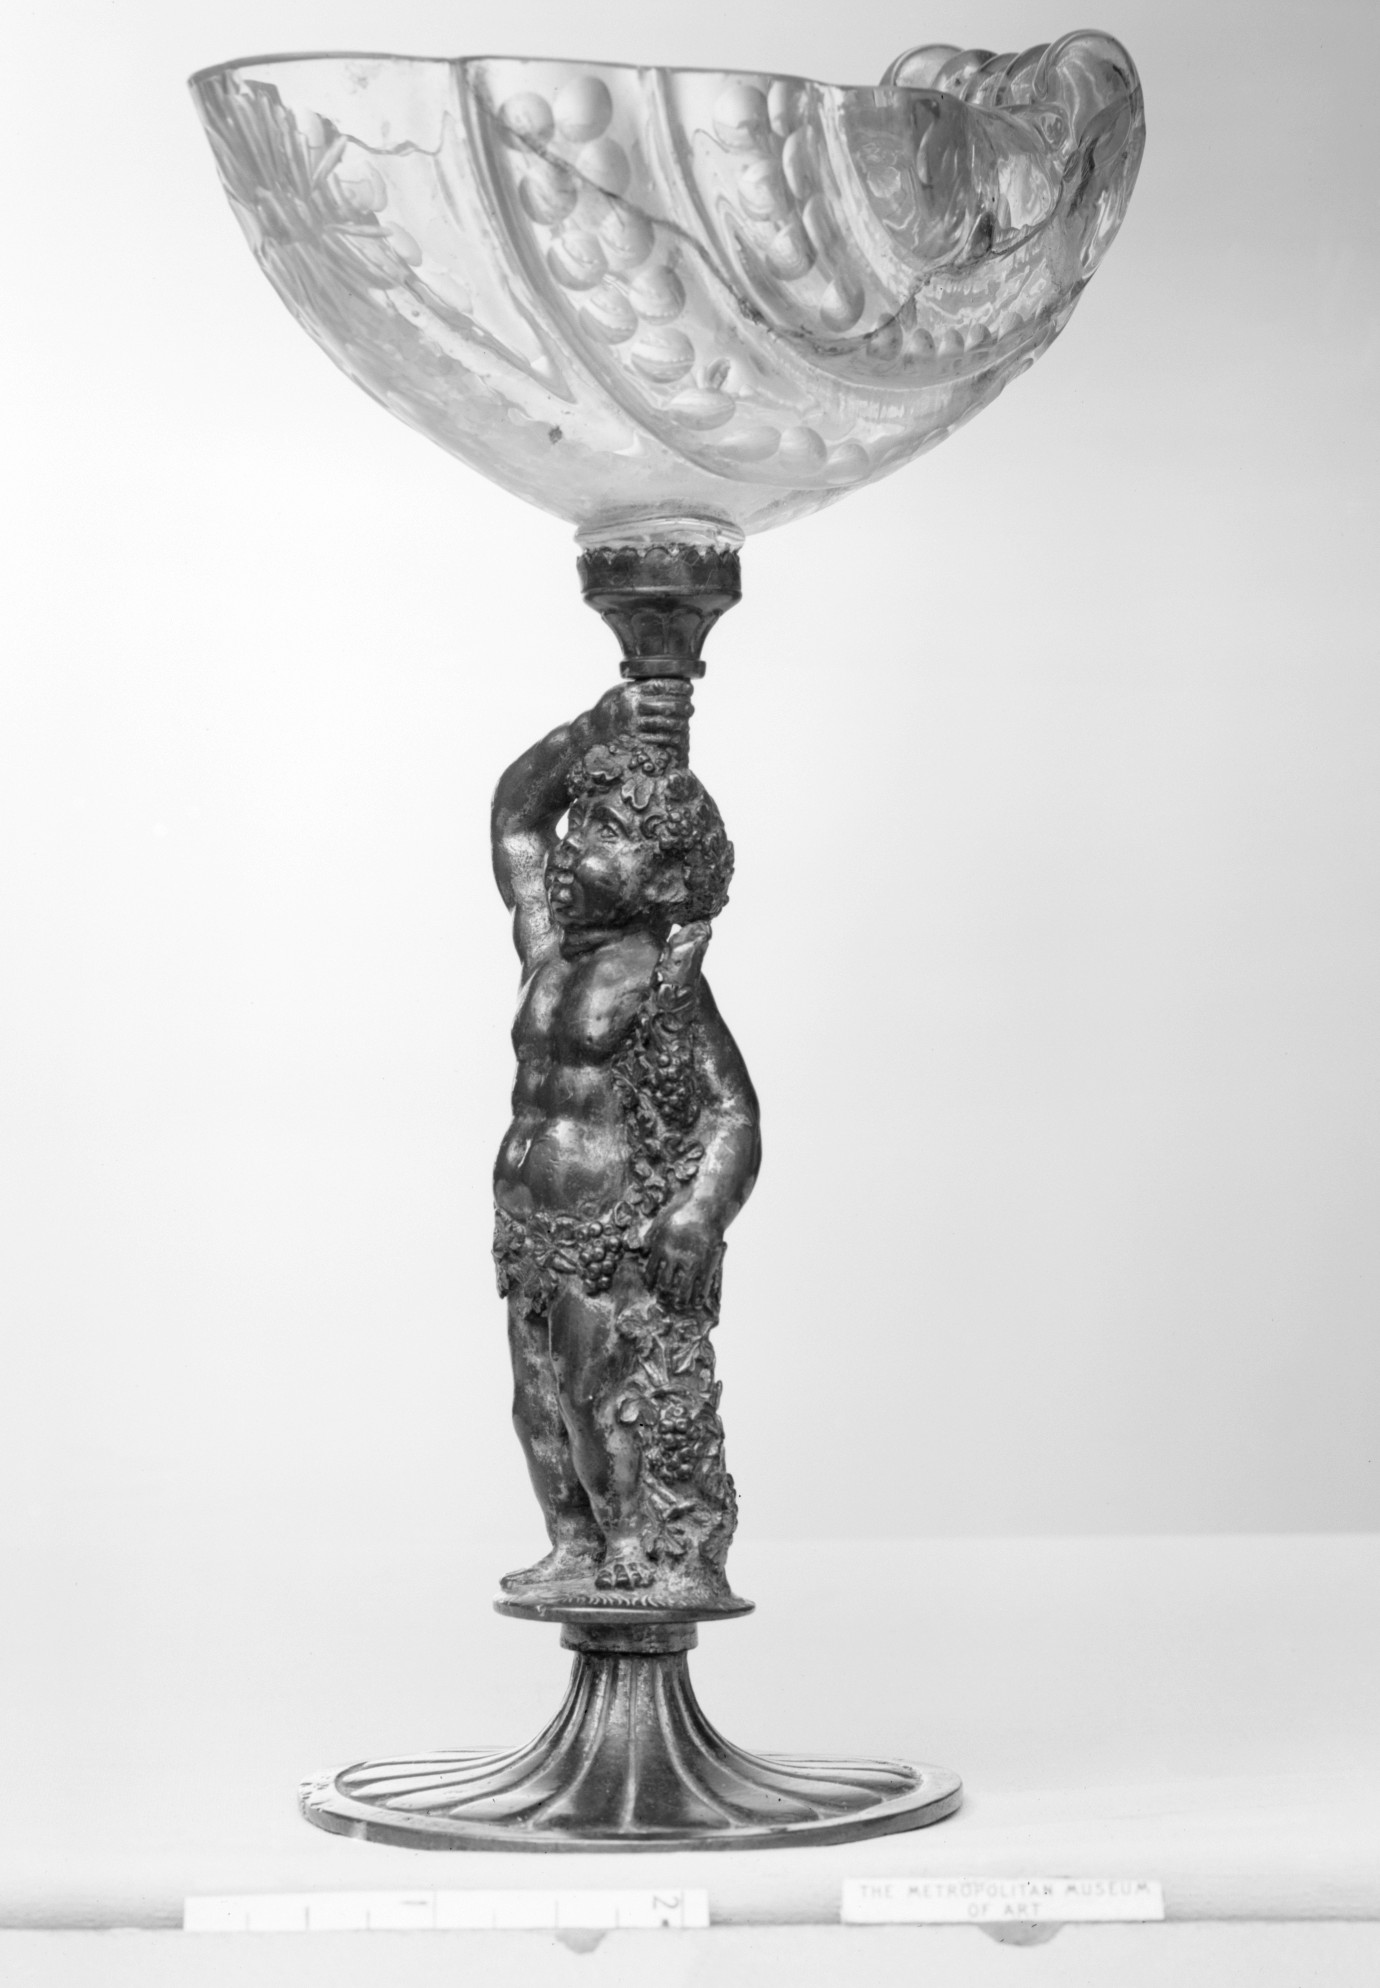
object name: saltcellar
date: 1551-1600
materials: gilt bronze, quartz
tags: boys